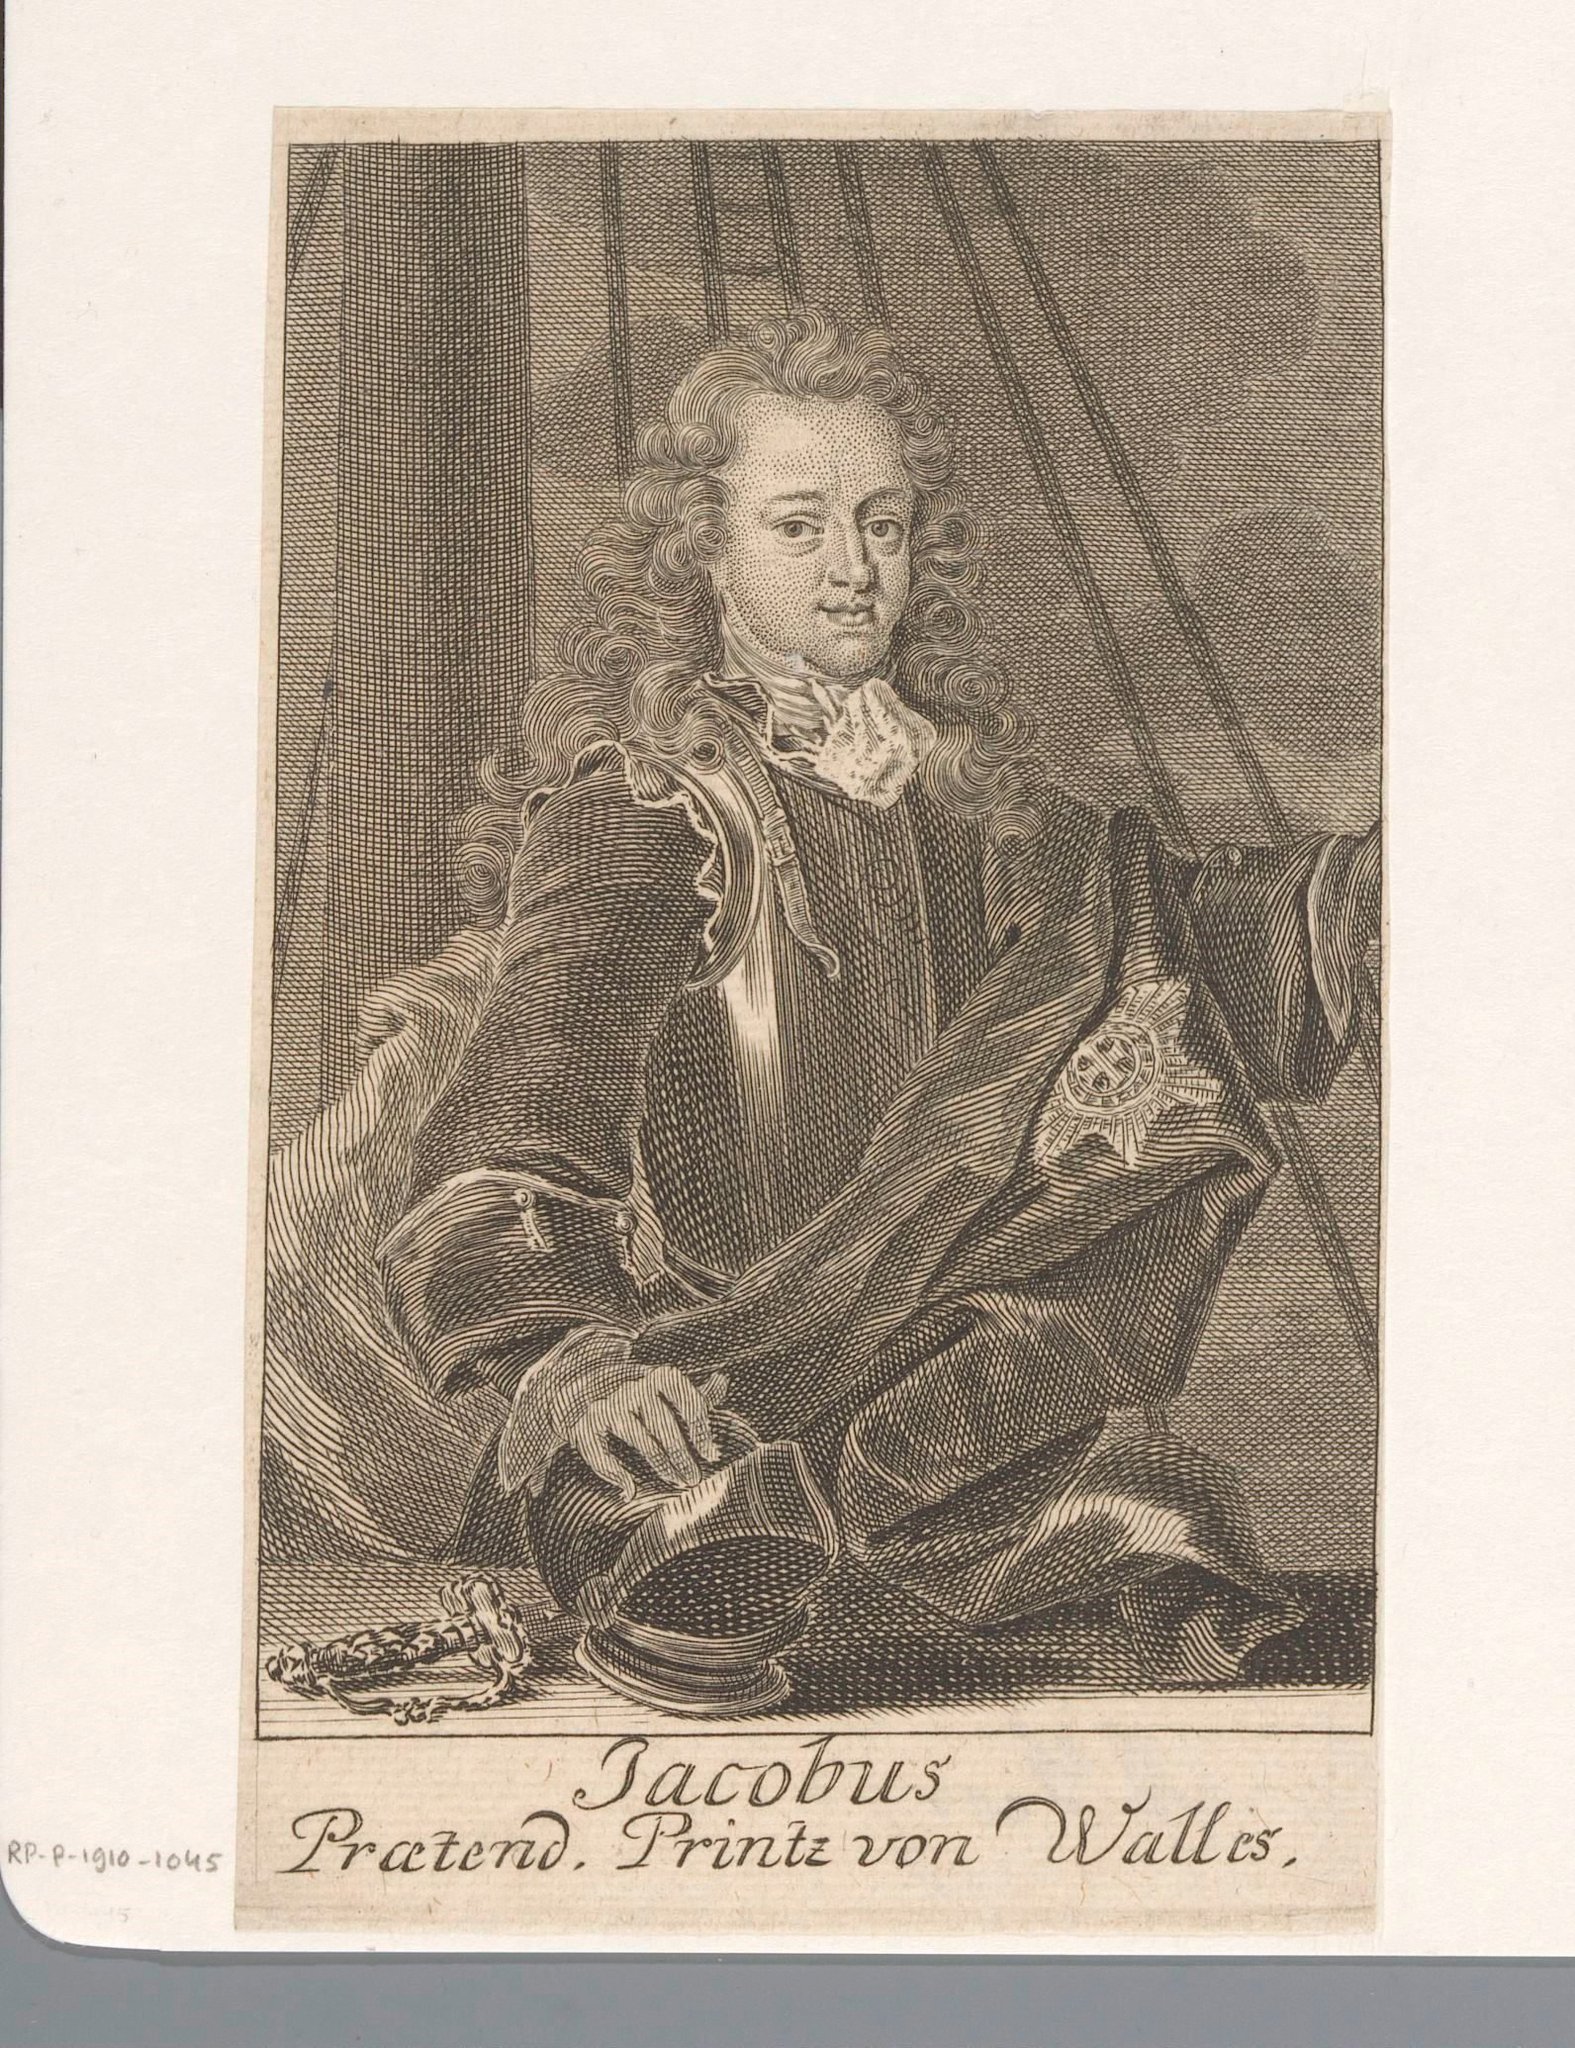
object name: print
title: Portret van Jacobus Frans Eduard Stuart, prins van Wales, troonpretendent van Groot-Brittannië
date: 1701-1766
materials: paper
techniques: engraving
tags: london, rome, helmet, knighthood order (garter) - insignia of a knighthood order, e.g.: badge, chain, historical persons, hacking and thrusting weapons: sword, parts of ship's exterior: mast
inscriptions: collector's mark: Lugt 2228